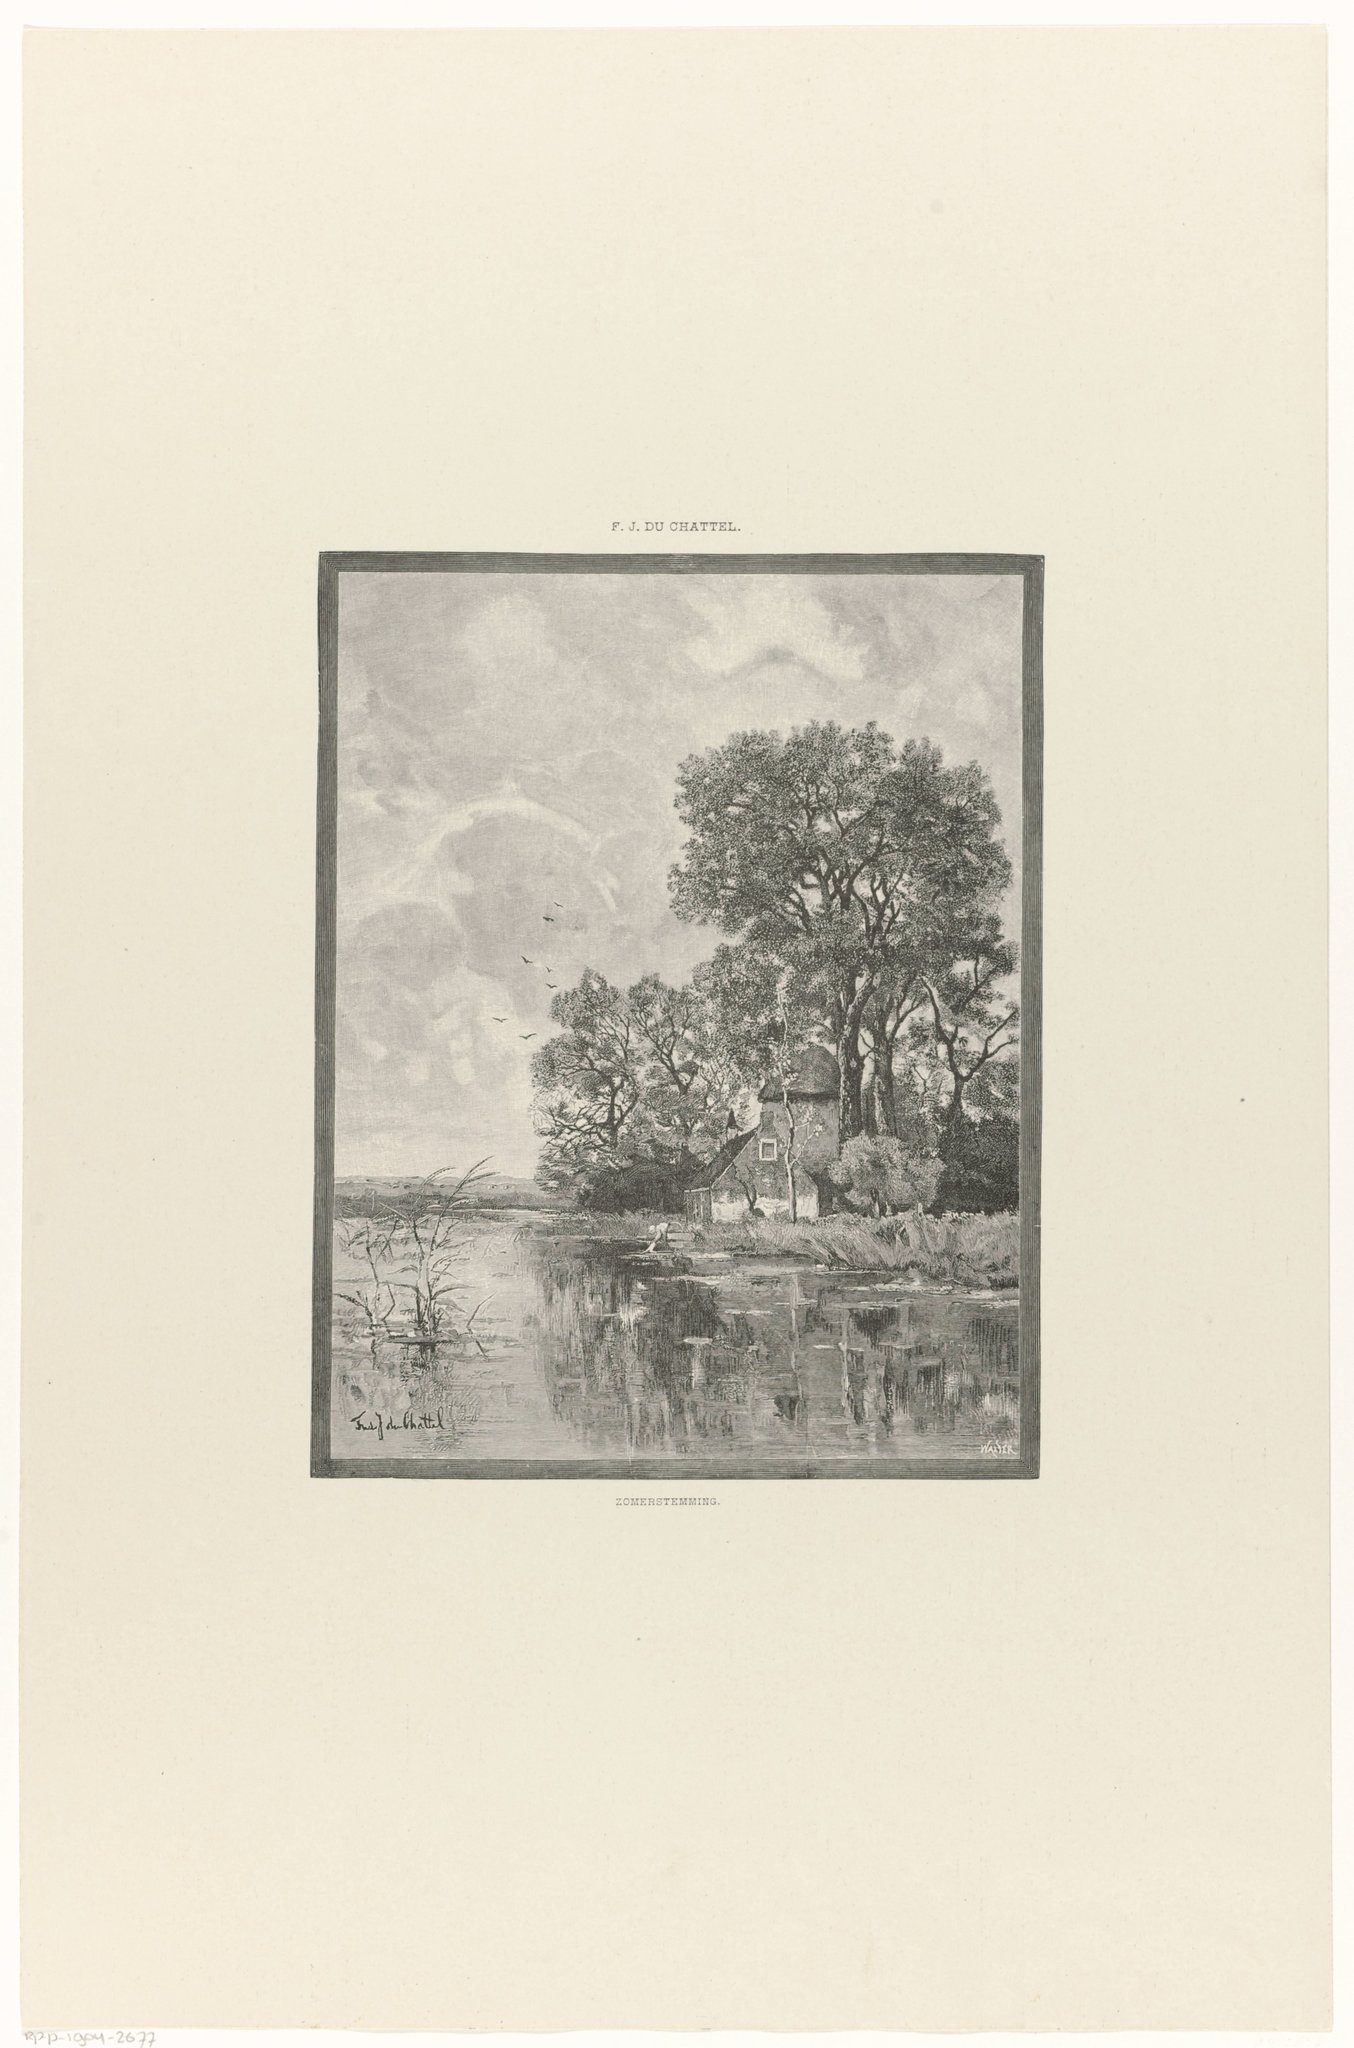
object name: print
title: Zomerstemming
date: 1849-1895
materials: paper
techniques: engraving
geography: netherlands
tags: river, farm or solitary house in landscape, vecht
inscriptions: collector's mark: Lugt 2228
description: Landschap met een boerderij aan de rivier de Vecht bij Vreeland.